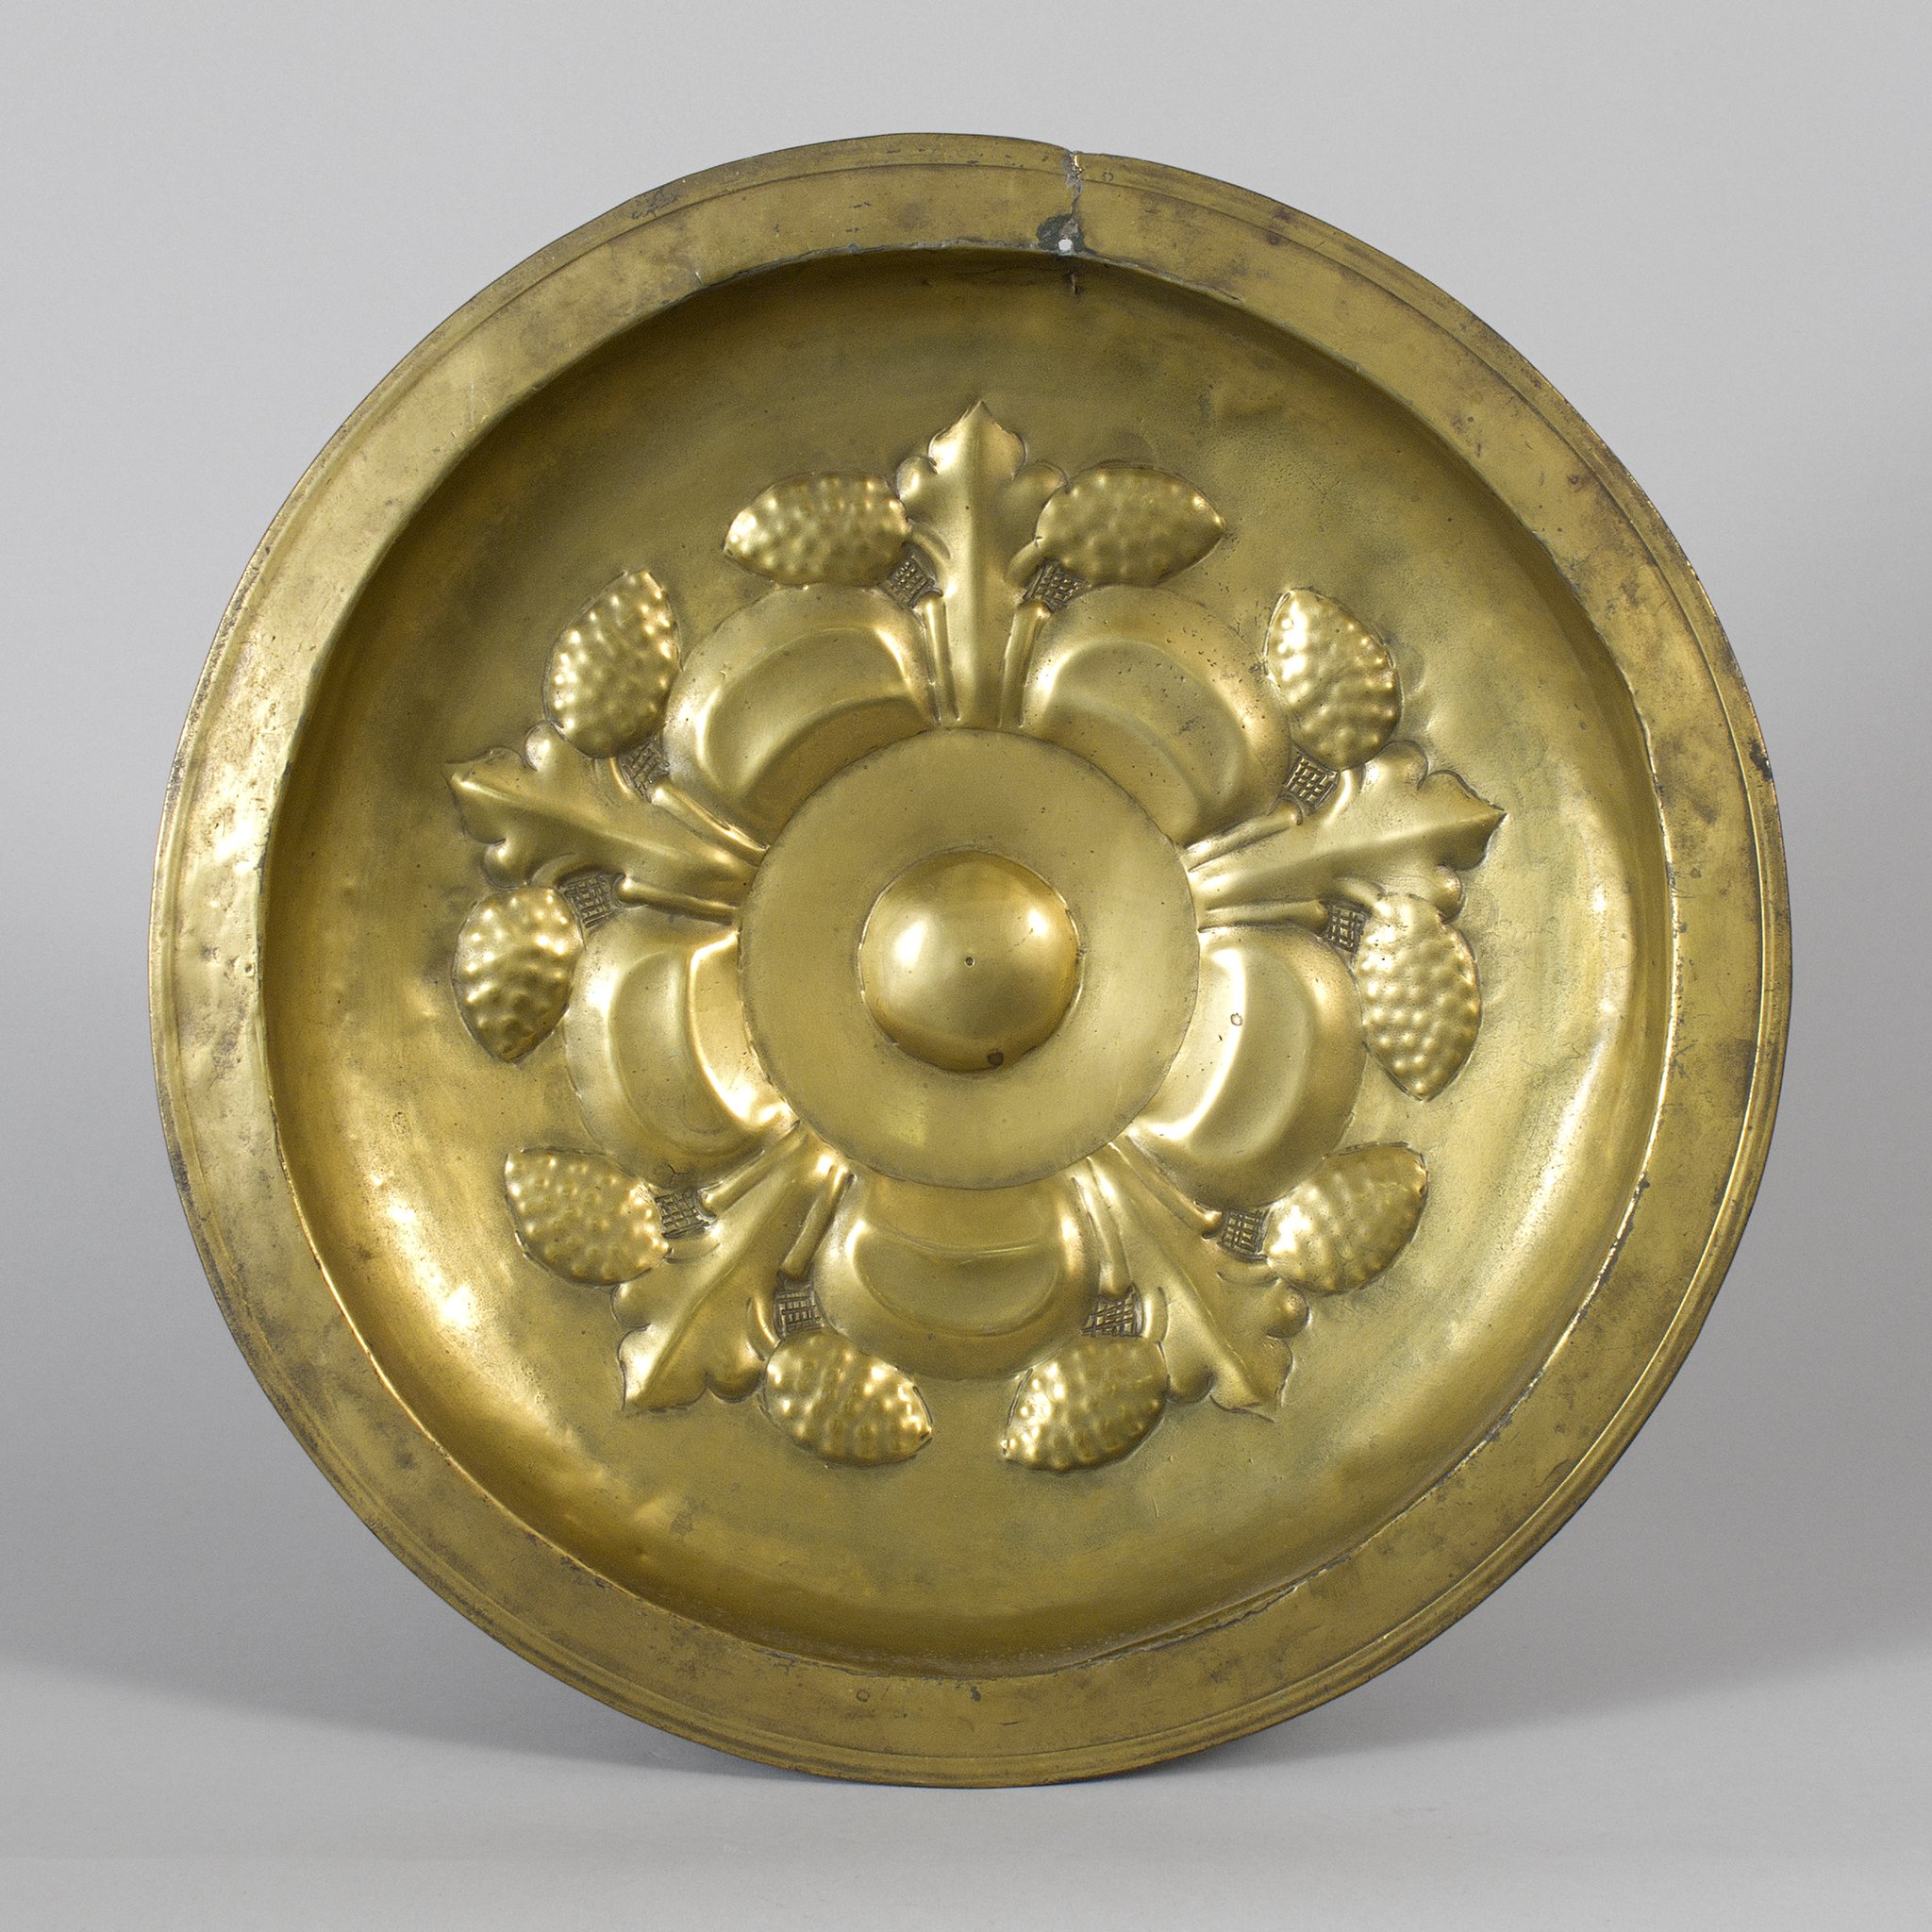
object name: dish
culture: german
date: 1501-1600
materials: brass